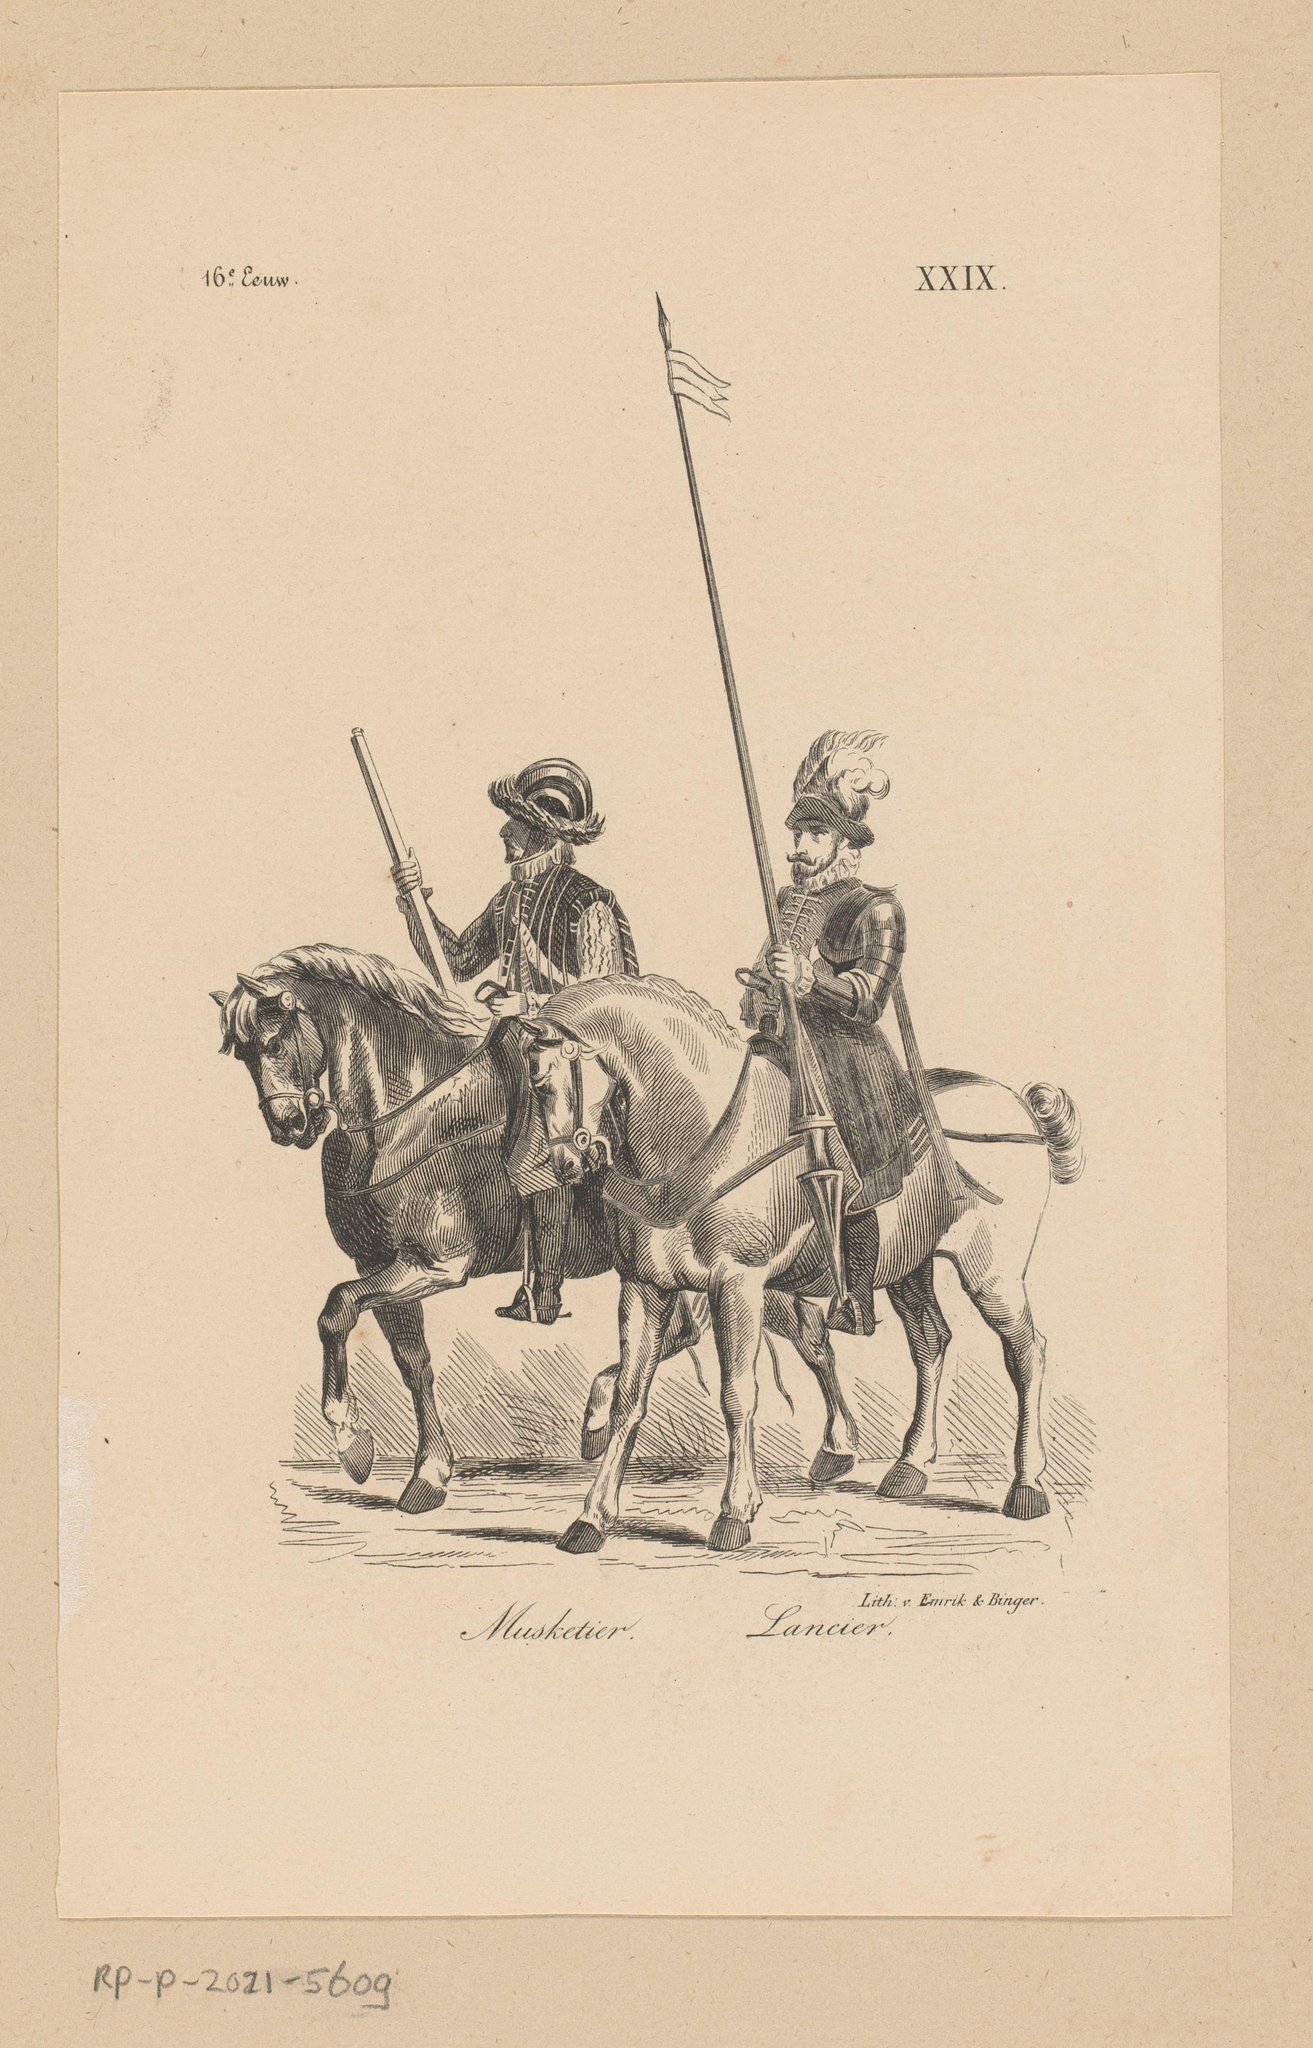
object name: costume print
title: Musketier en lansier in kleding uit de zestiende eeuw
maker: Anonymous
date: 1857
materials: paper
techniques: lithograph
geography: haarlem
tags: riding a horse, ass, or mule; rider, horseman, helved weapons, polearms (for striking, hacking, thrusting): lance, clothes, costume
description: Prent waarschijnlijk uit: Hofdijk, Willem Jacob. Schets van de geschiedenis der Nederlanden. Amsterdam: Gebroeders Binger, 1857.